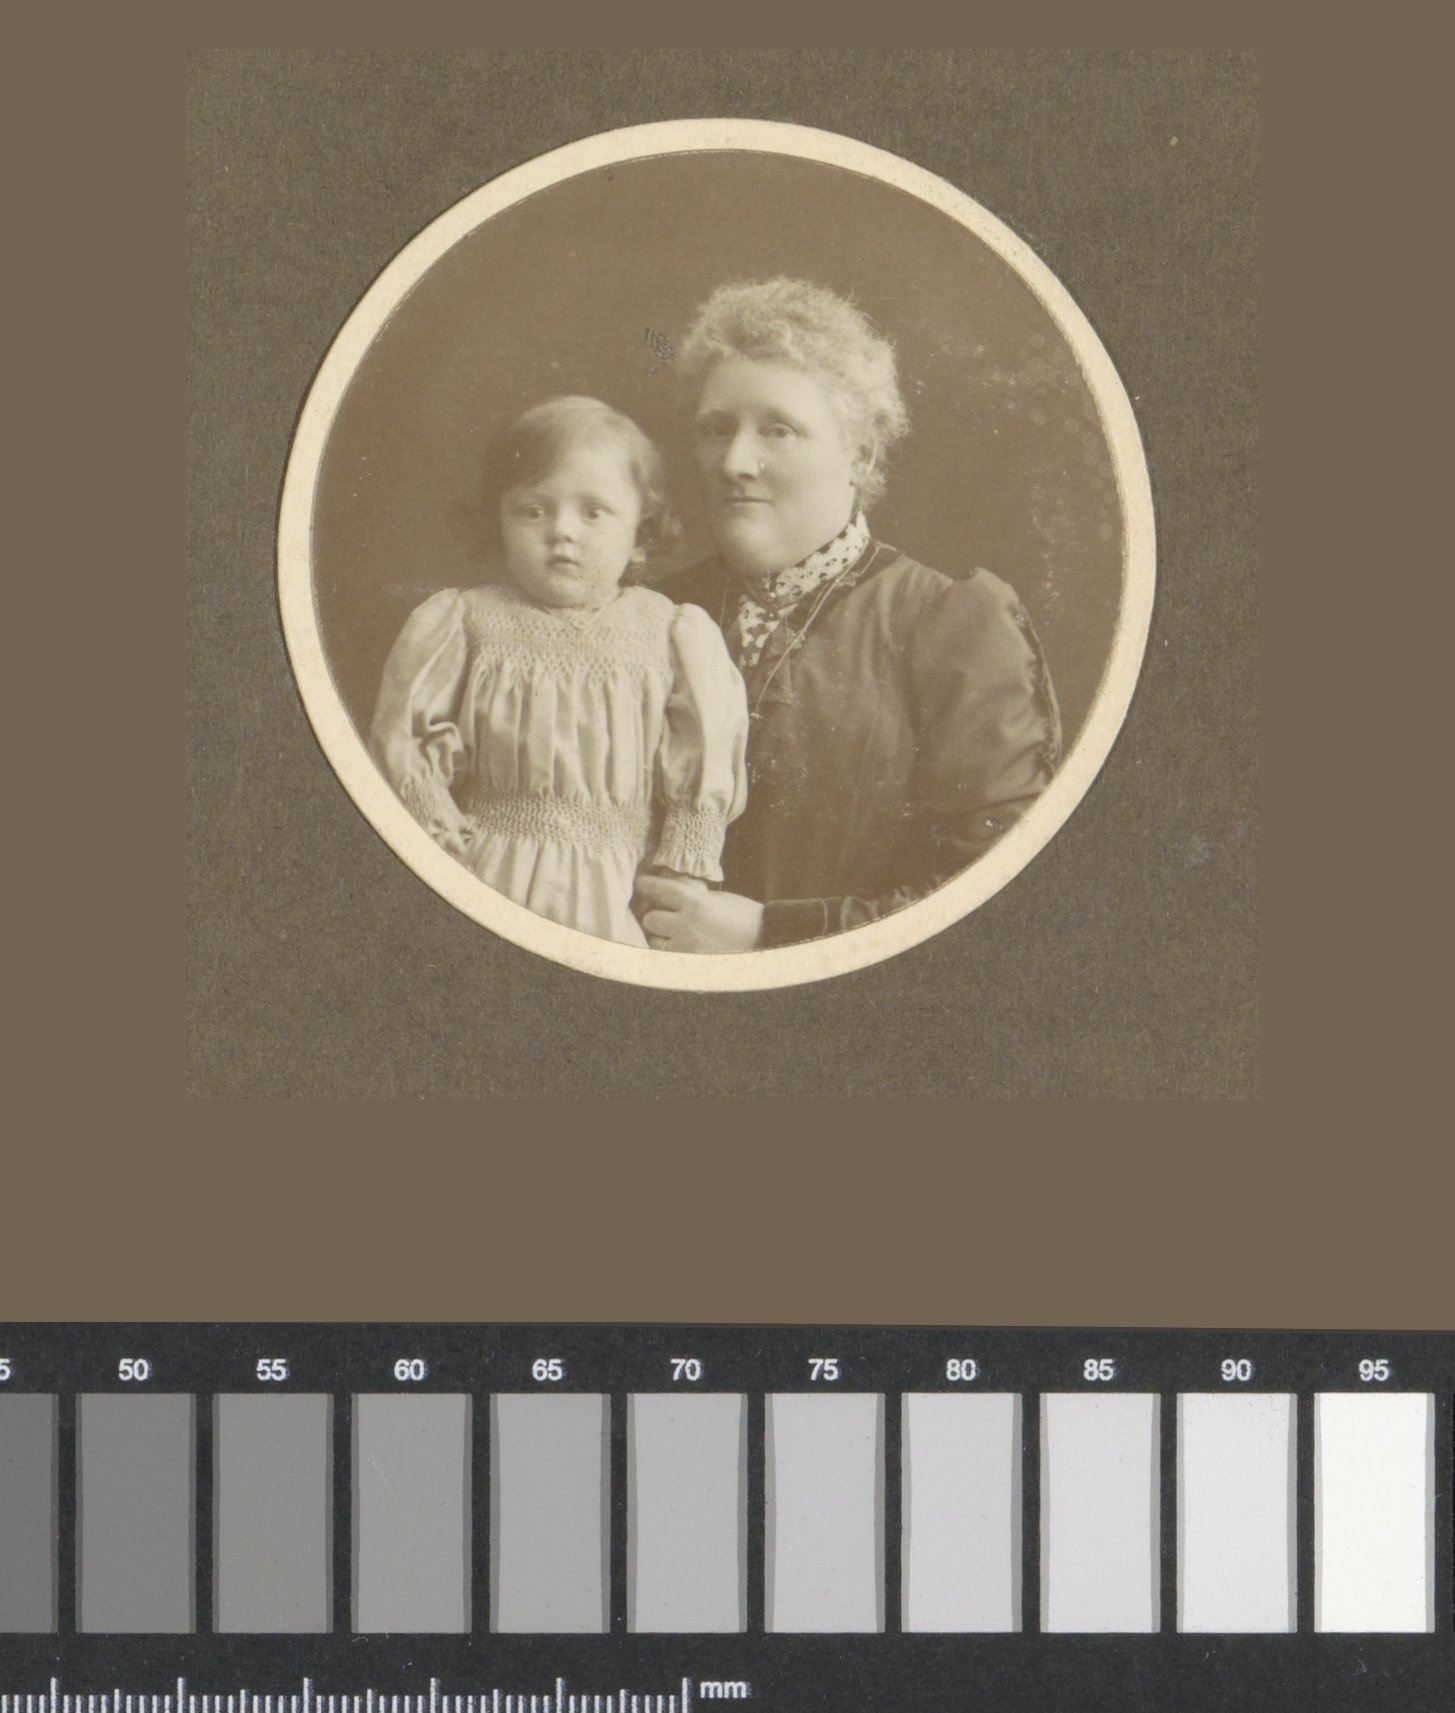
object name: photograph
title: Portret van G. Vermeulen-Luitjes met een kind op schoot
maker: cornelis johannes lodewicus vermeulen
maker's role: fotograaf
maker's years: 1861-1936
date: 1900-1920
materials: paper, photographic support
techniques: gelatin silver print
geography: the hague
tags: mother and baby or young child, the hague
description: Onderdeel van Fotoalbum met opnames van het gezin en het huis van fotograaf C.J.L. Vermeulen in Den Haag.